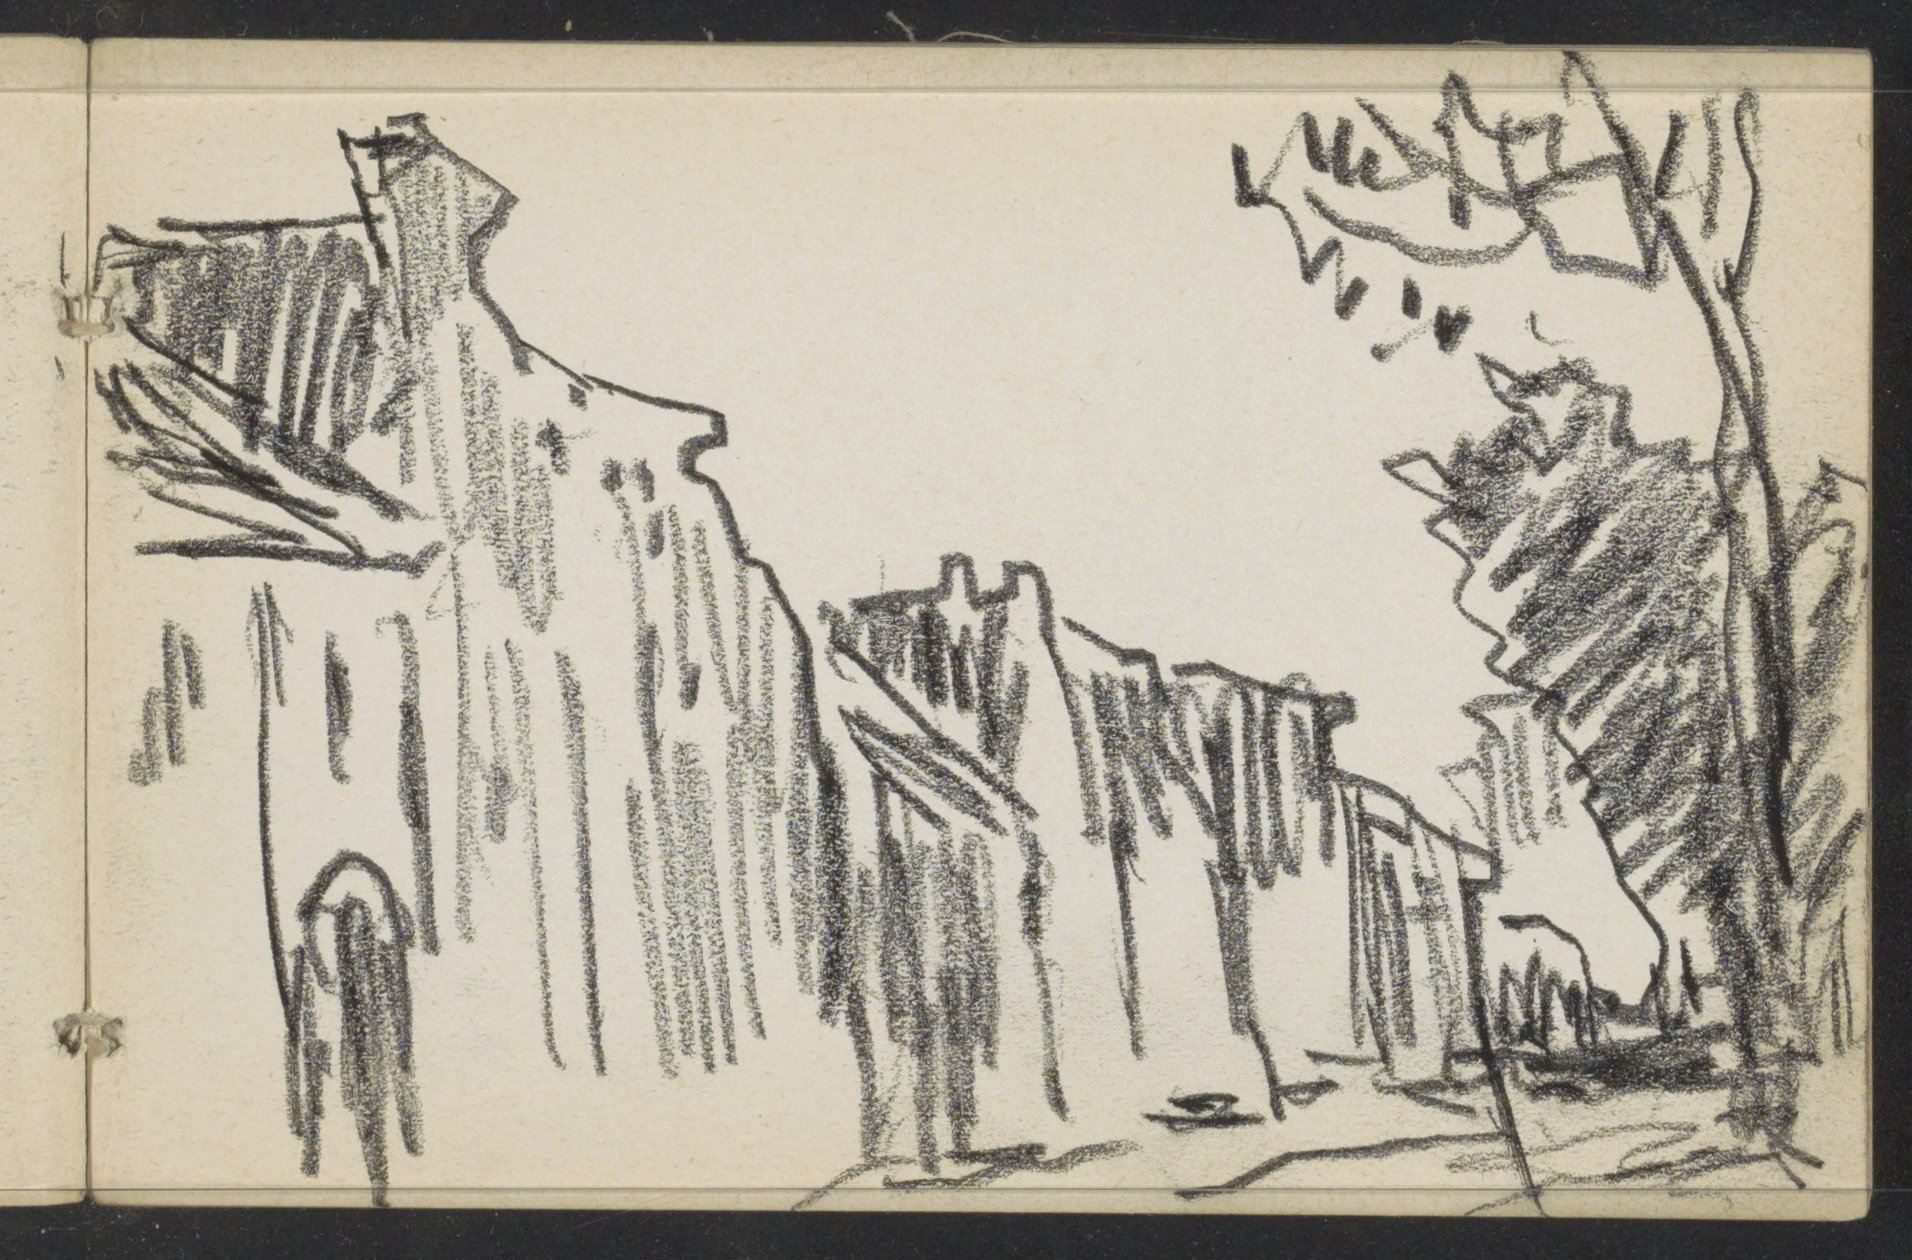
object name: sketchbook leaf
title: Rijtjeshuizen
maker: alexander shilling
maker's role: draughtsman, print maker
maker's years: 1859-1937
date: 1910-1923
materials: chalk, paper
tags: the usual house or row of houses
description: Blad 17 recto uit een schetsboek met 26 bladen.